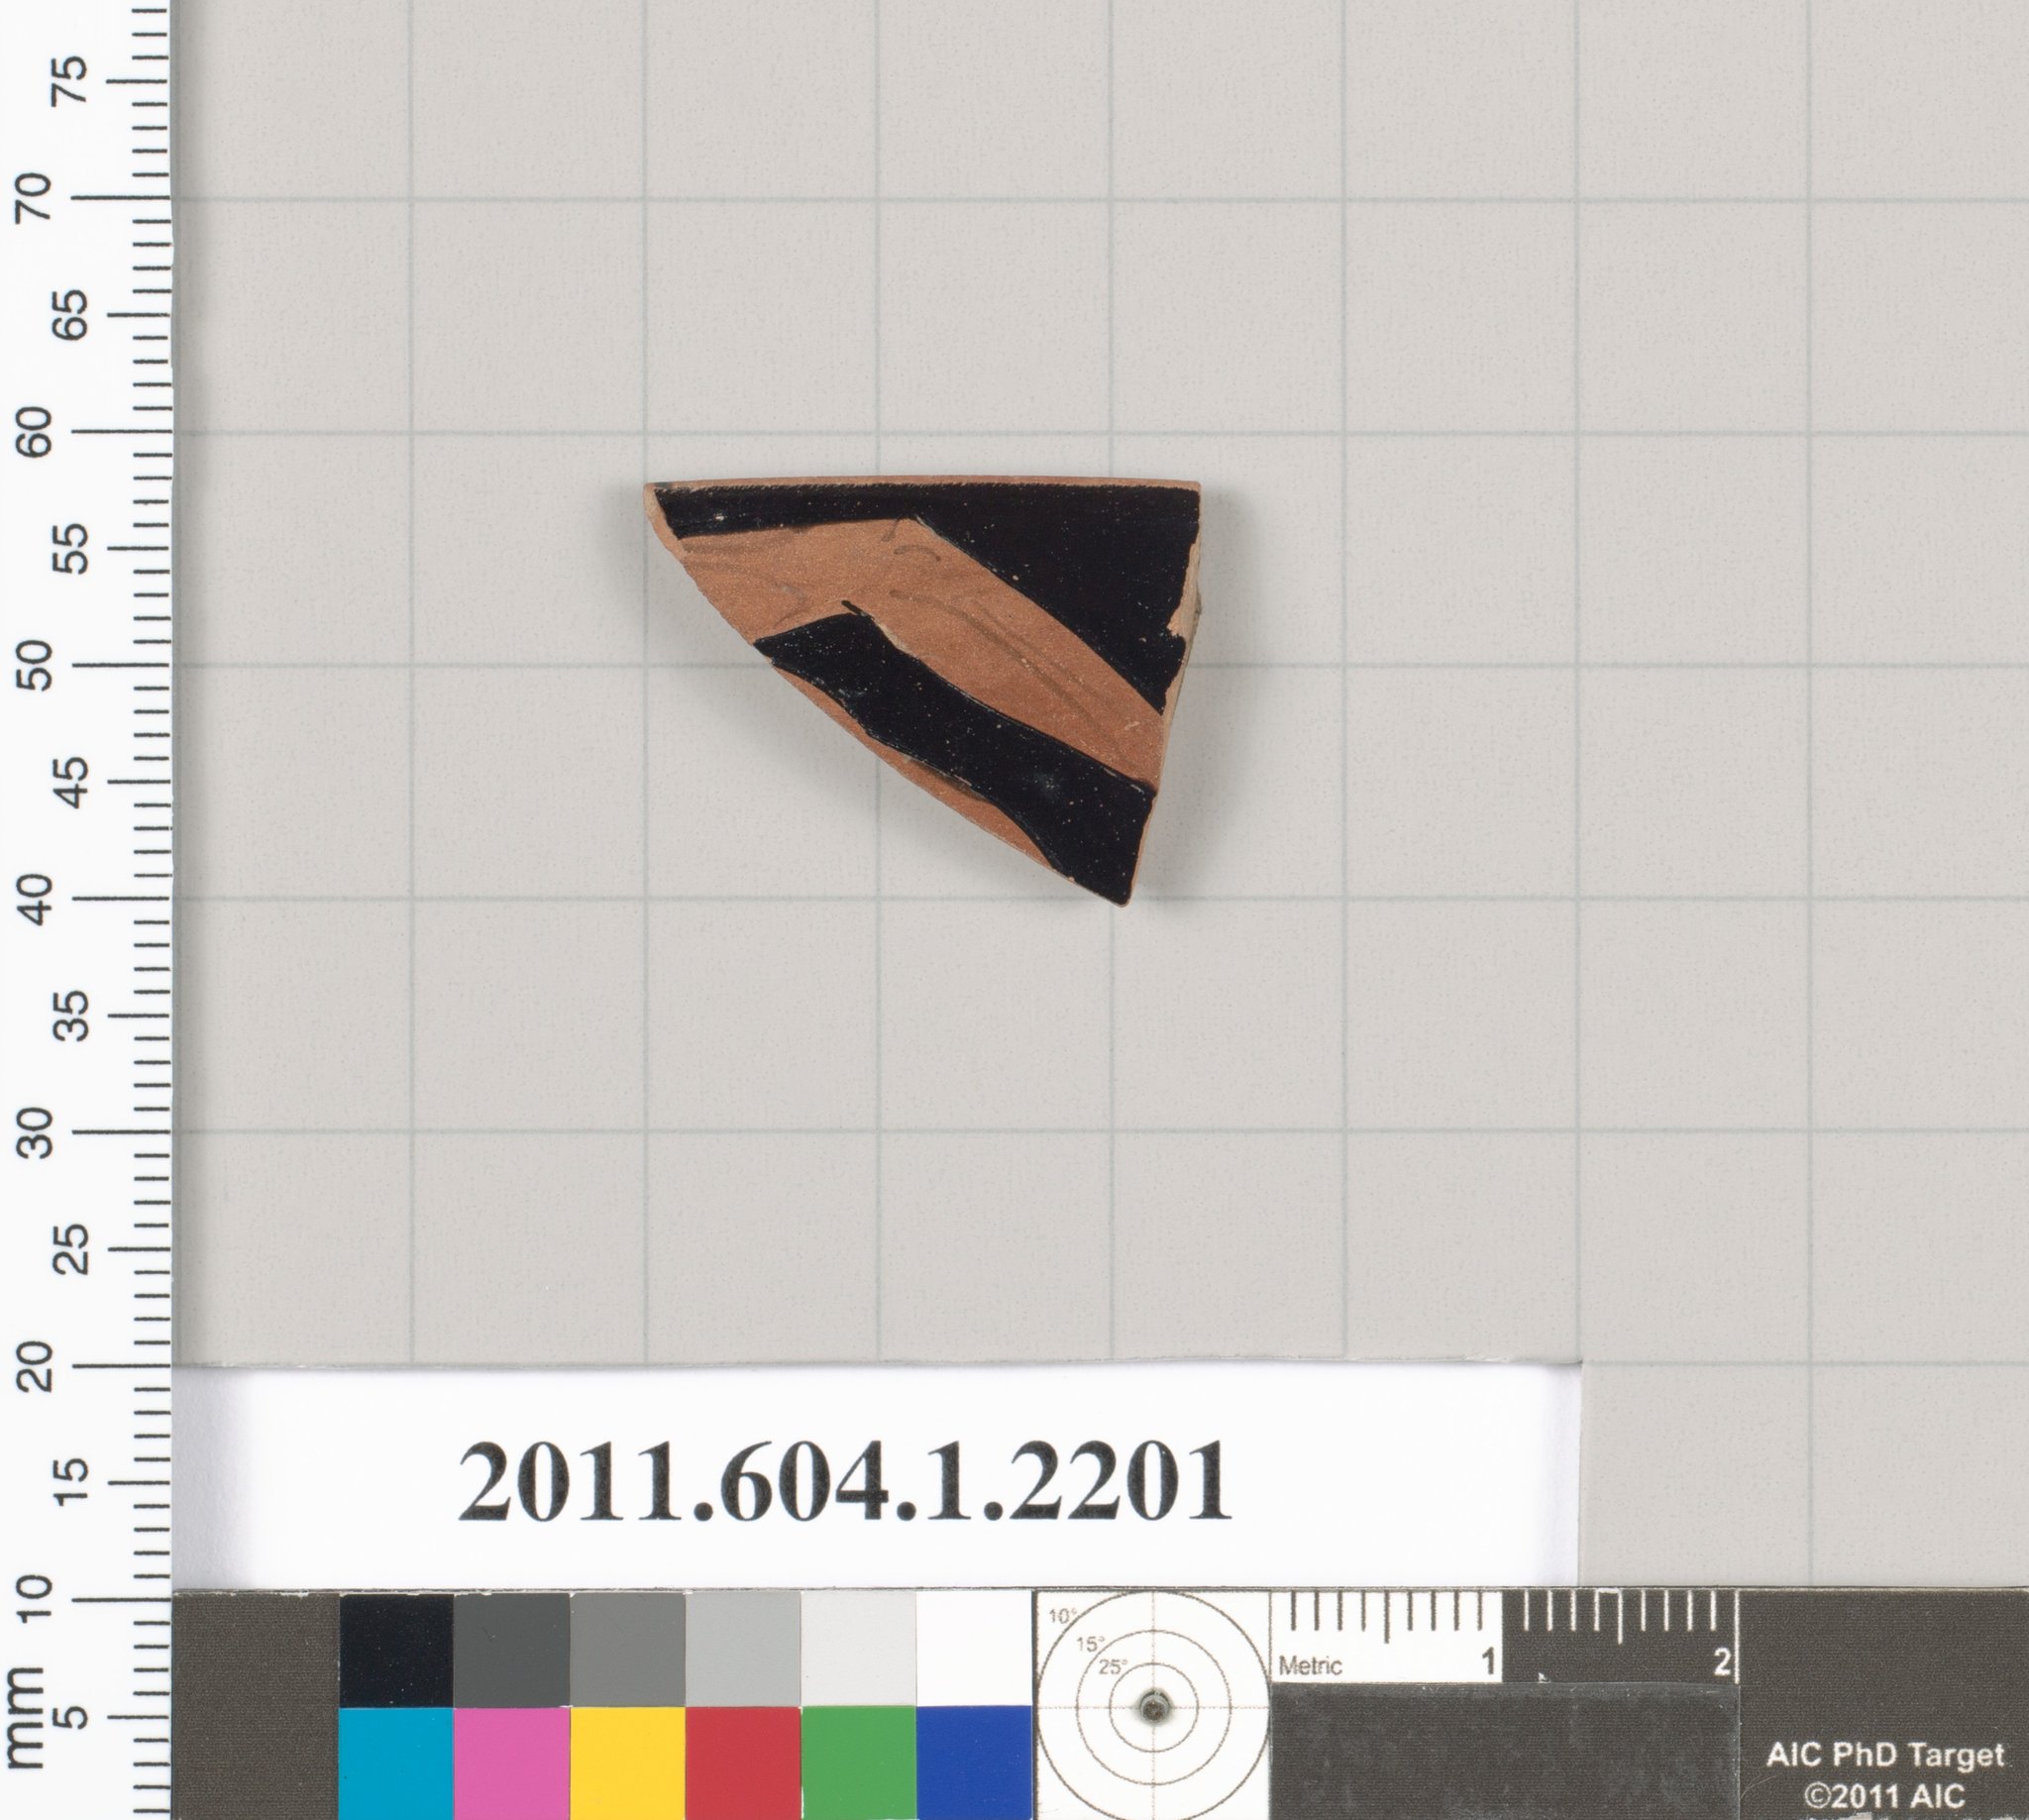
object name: kylix fragment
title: Terracotta rim fragment of a kylix (drinking cup)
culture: greek, attic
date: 500-476 BCE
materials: terracotta